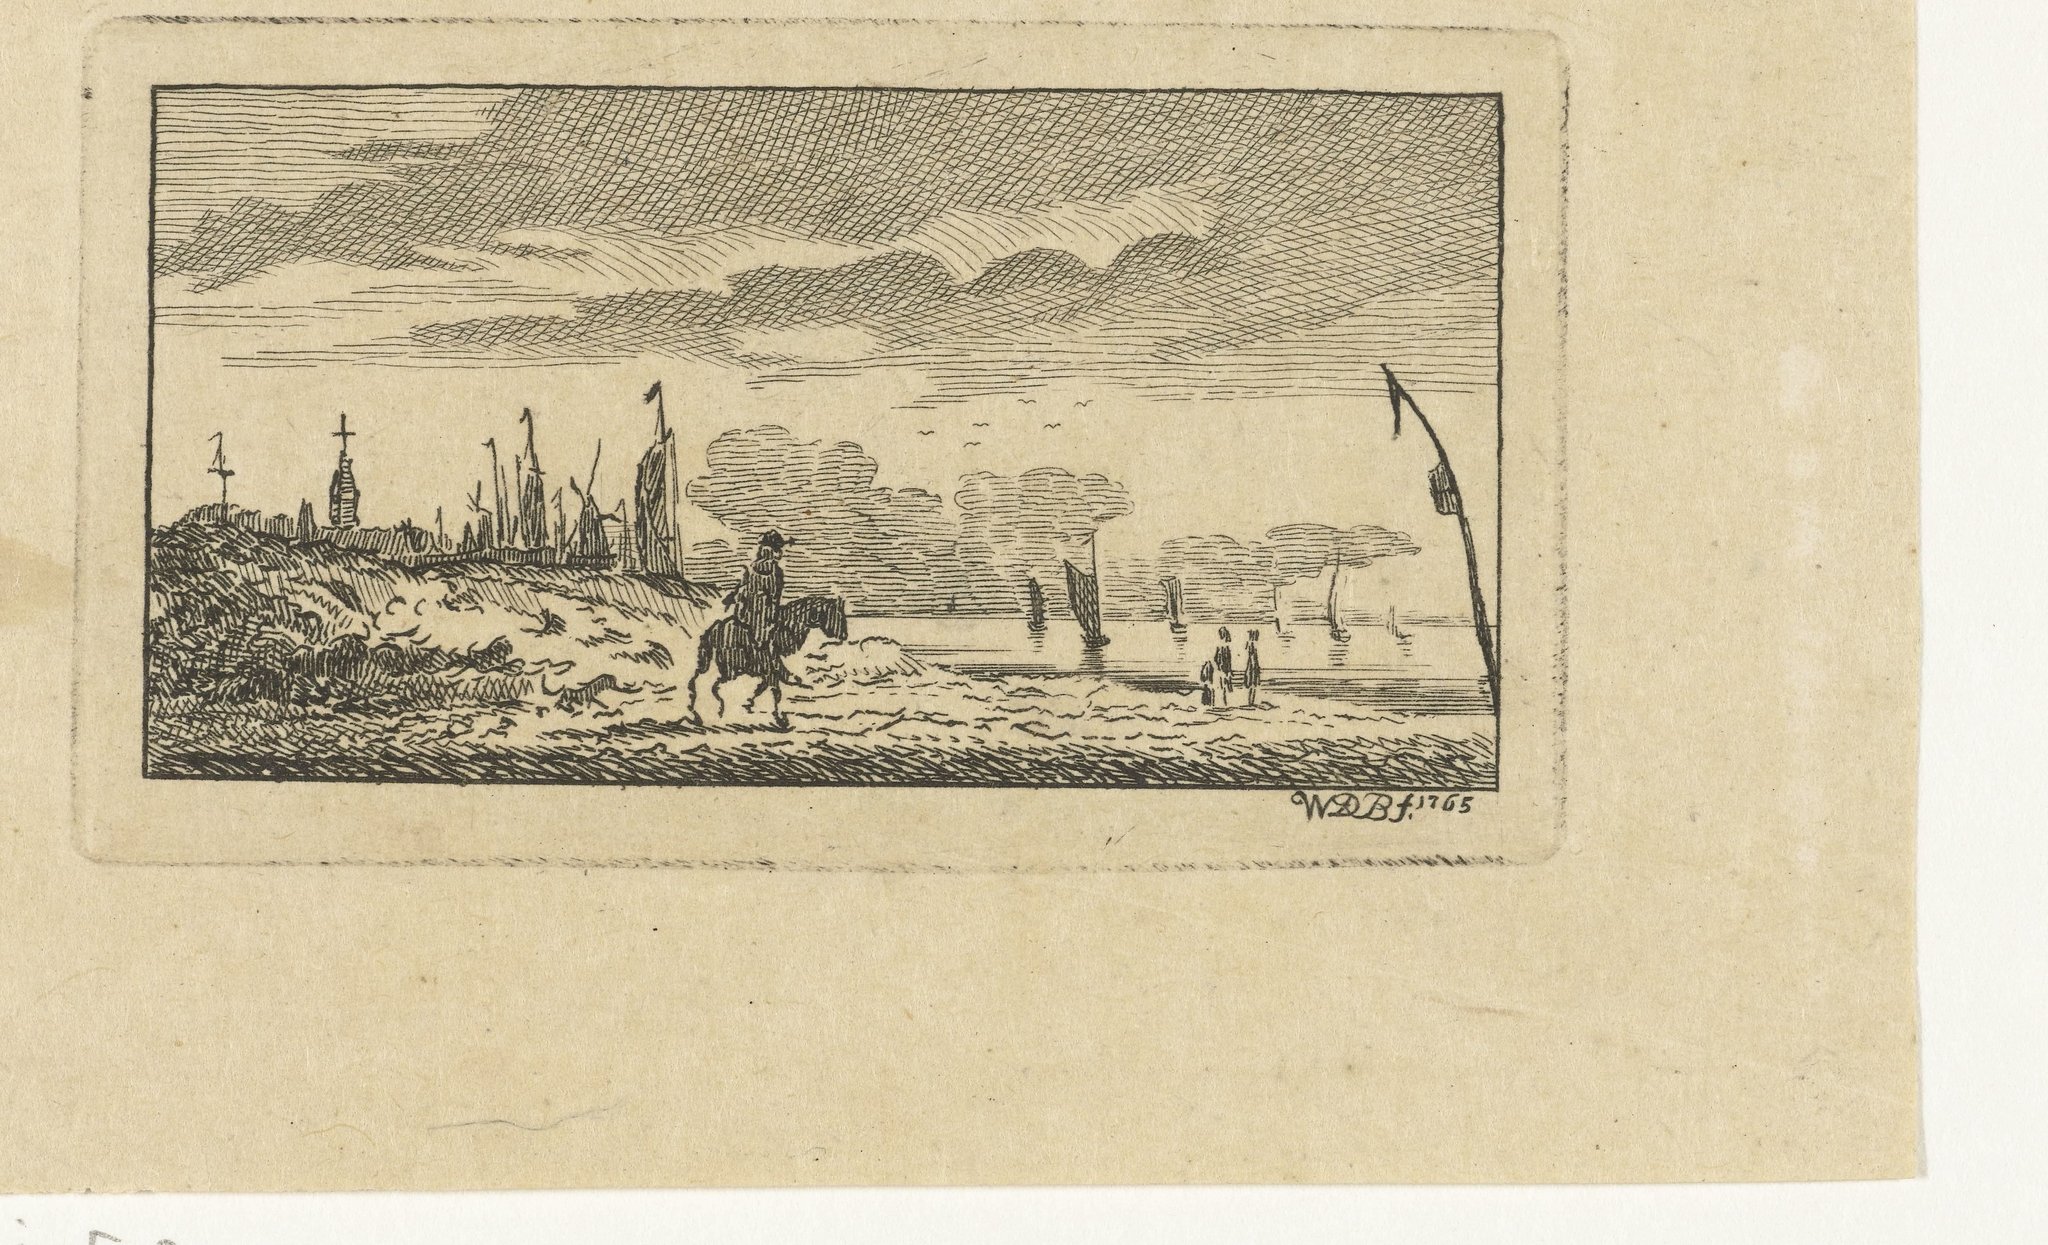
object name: print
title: Kustlandschap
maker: willem de bruin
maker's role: draughtsman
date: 1765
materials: paper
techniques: etching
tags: riding a horse, ass, or mule; rider, horseman, dune coast, beach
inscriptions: collector's mark: Lugt 240, inscription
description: Landschap met duinen en het strand. Een ruiter met paard en enkele wandelaars op het strand. In de verte een haven. Enkele bootjes op het water